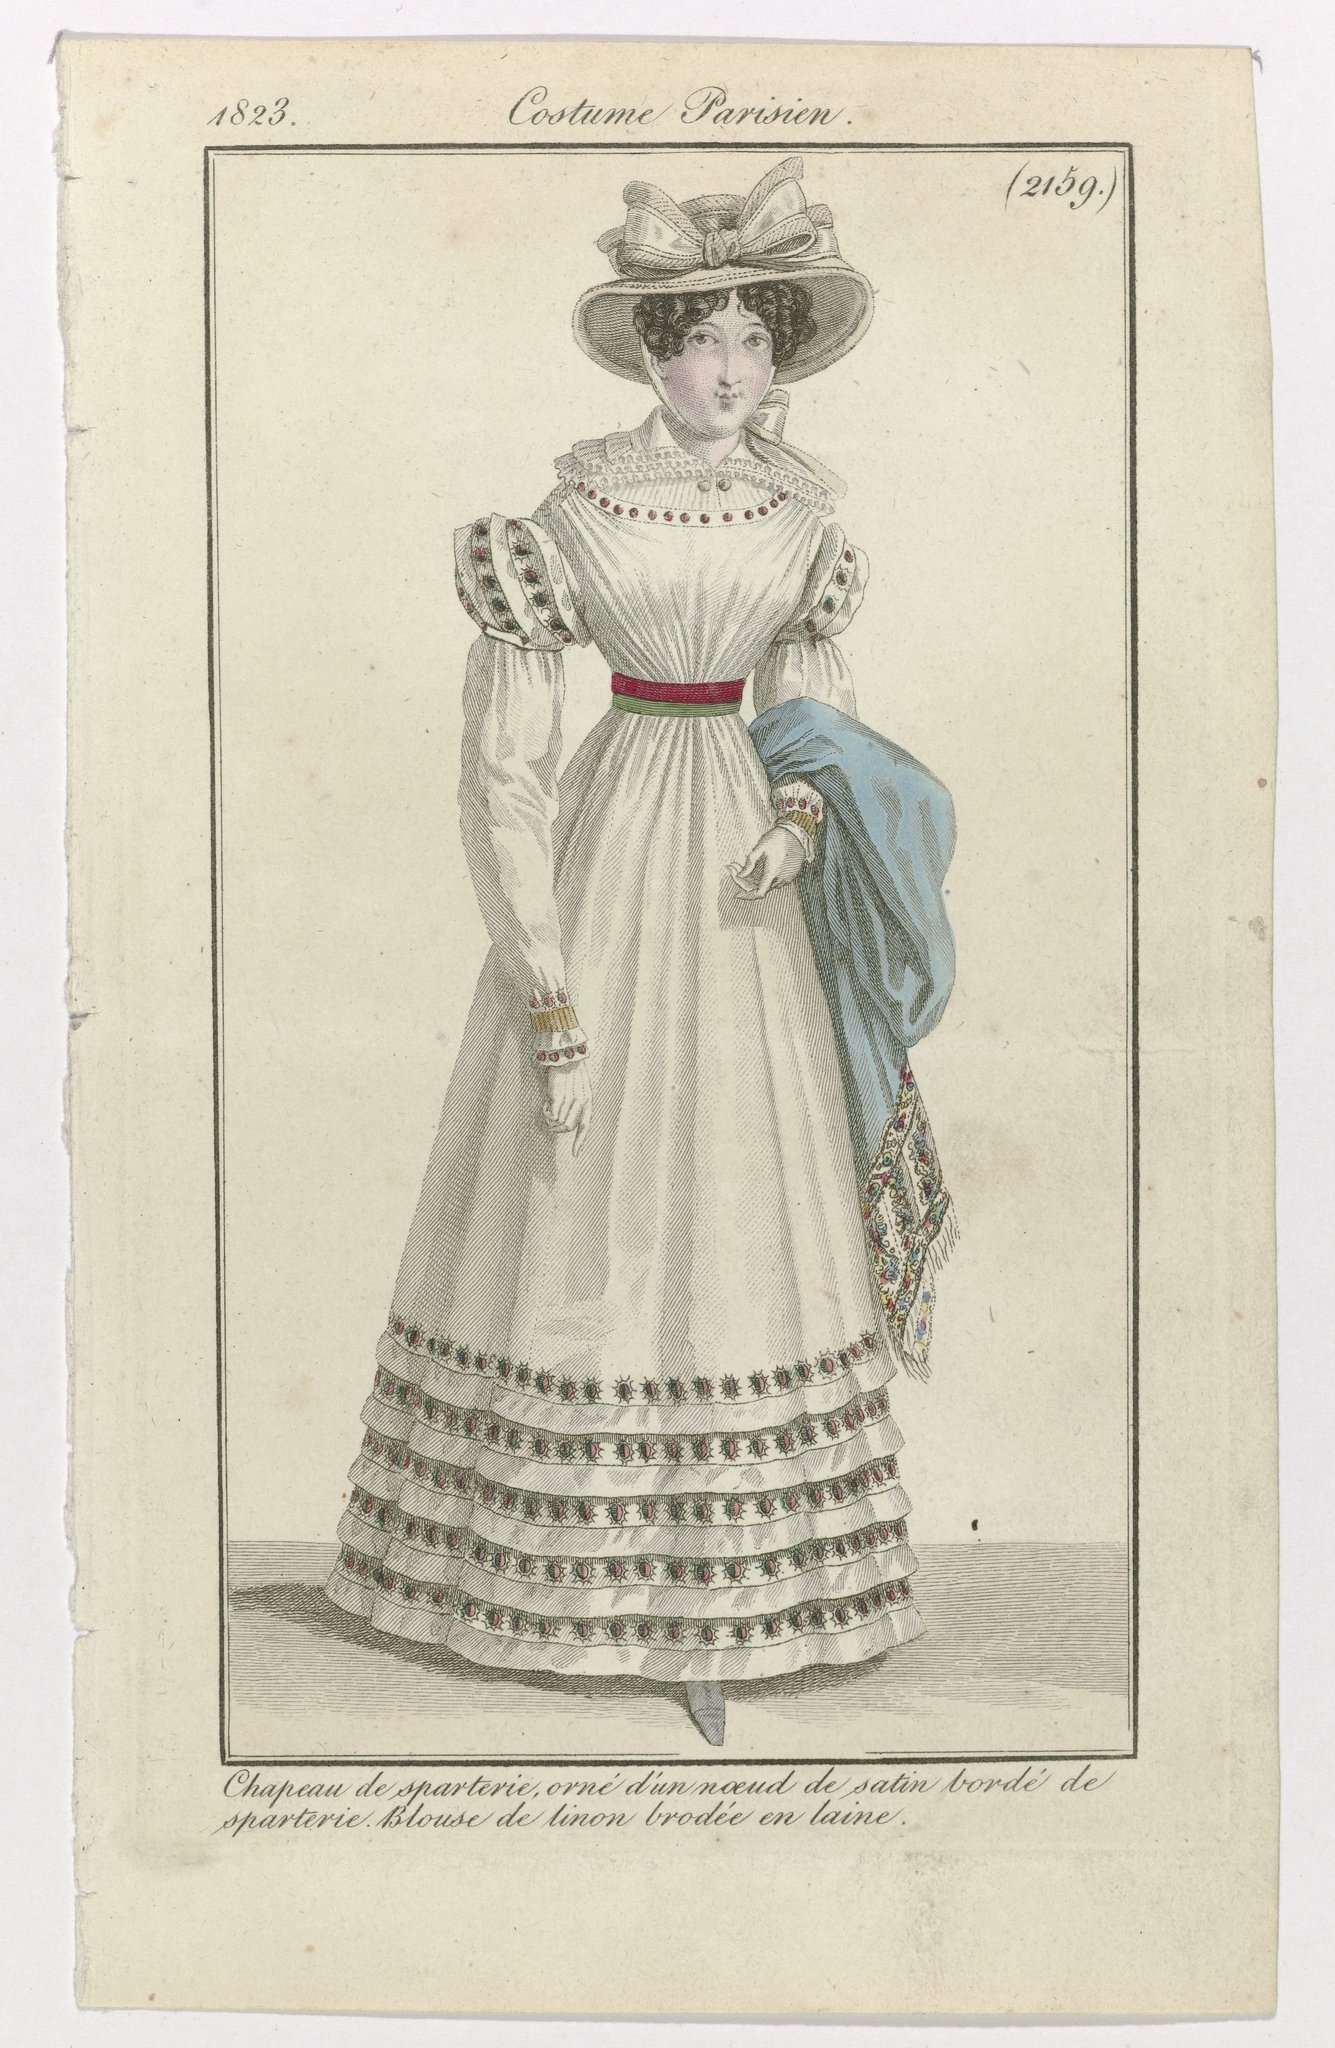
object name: fashion print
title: Journal des Dames et des Modes, Costume Parisien, 15 juin 1823, (2159): Chapeau de sparteri (...)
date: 1823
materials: paper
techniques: engraving, hand coloring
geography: paris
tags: bow (ornamental part of clothing) (+ women's clothes), clothing for the upper part of the body (shawl) (+ women's clothes), clothing for the upper part of the body: blouse (+ women's clothes), fashion plates, head-gear: hat (+ women's clothes), shoes, sandals (+ women's clothes), gloves, mittens, etc. (+ women's clothes), dress, gown (+ women's clothes), neck-gear ~ clothing (+ women's clothes), bracelet, wristlet (+ women's clothes), belt, girdle, waistband (+ women's clothes)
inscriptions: caption: ‘Chapeau de sparterie, orné d'un noeud de satin bordé de sparterie. Blouse de linon brodée en laine.’, title: ‘Costume Parisien.’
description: Vrouw met op het hoofd een hoed van 'sparterie' (gevlochten plantenvezels) versierd met een satijnen strik afgezet met idem 'sparterie'. Zij draagt een blouse van linnen geborduurd met wol. Verdere accessoires: ceintuur, sjaal afgezet met franjes, handschoenen, schoen met vierkante neus. De prent maakt deel uit van het modetijdschrift Journal des Dames et des Modes, uitgegeven door Pierre de la Mésangère, Parijs, 1797-1839.